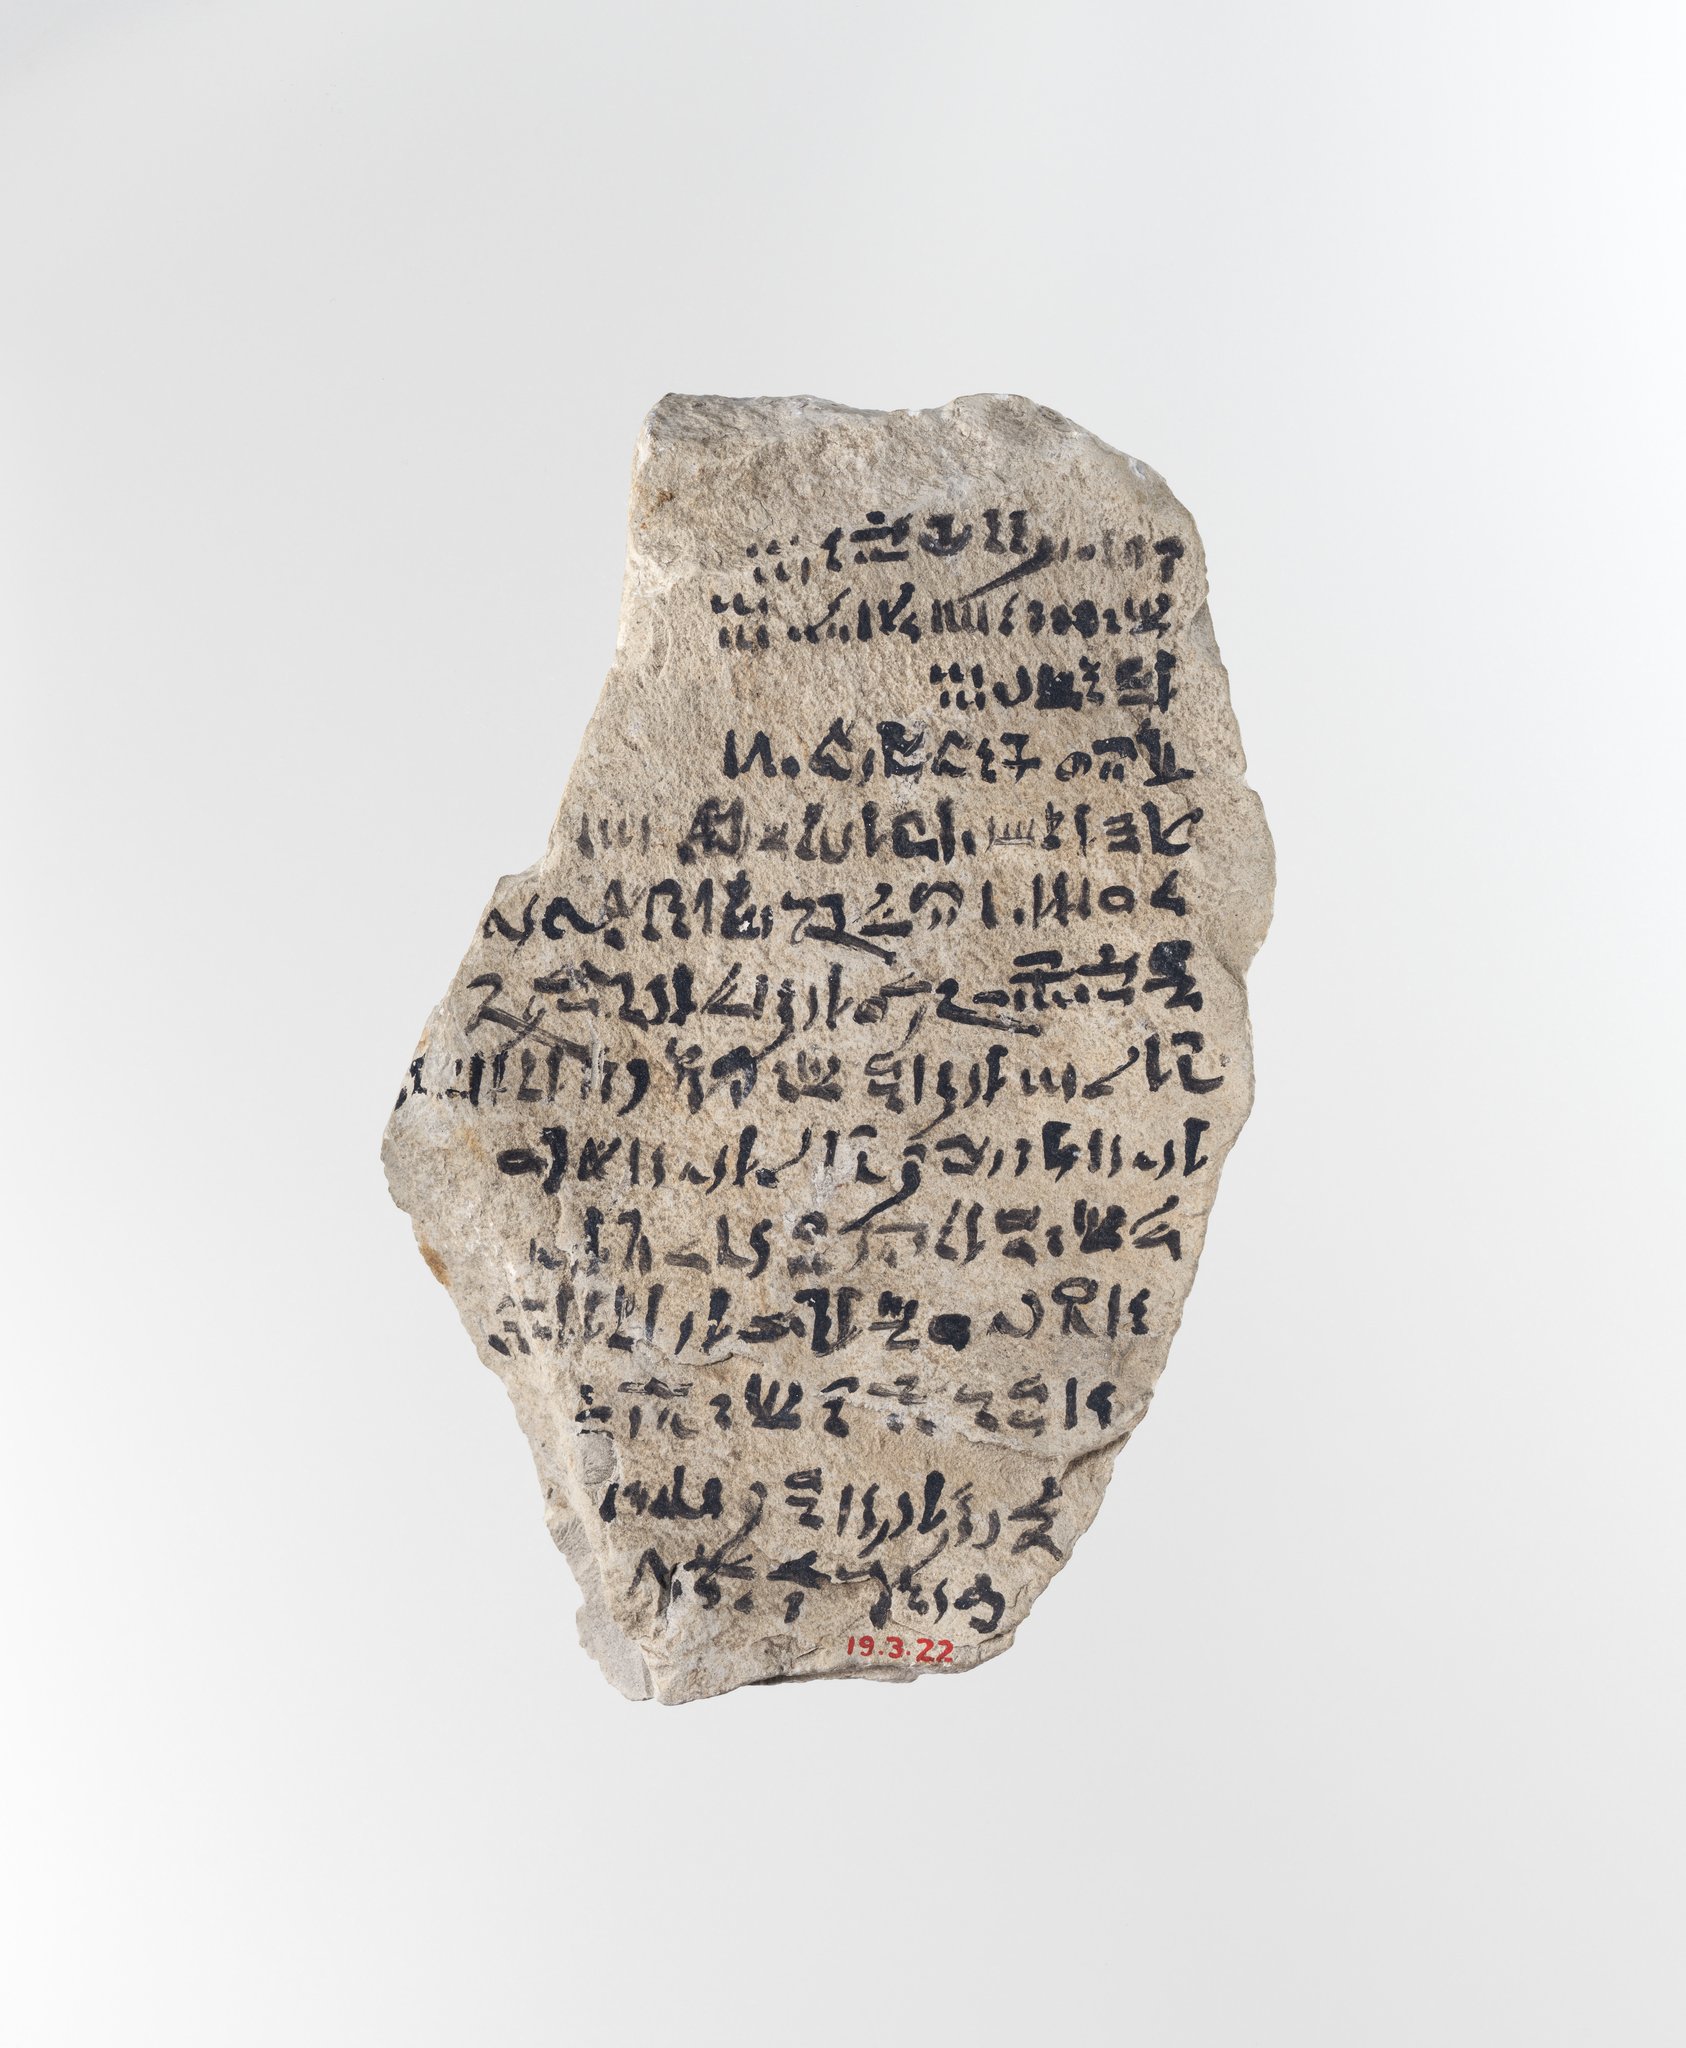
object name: ostracon, hieratic, account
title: Ostracon with hieratic inscription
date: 1295-525 BCE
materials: ink, limestone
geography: egypt